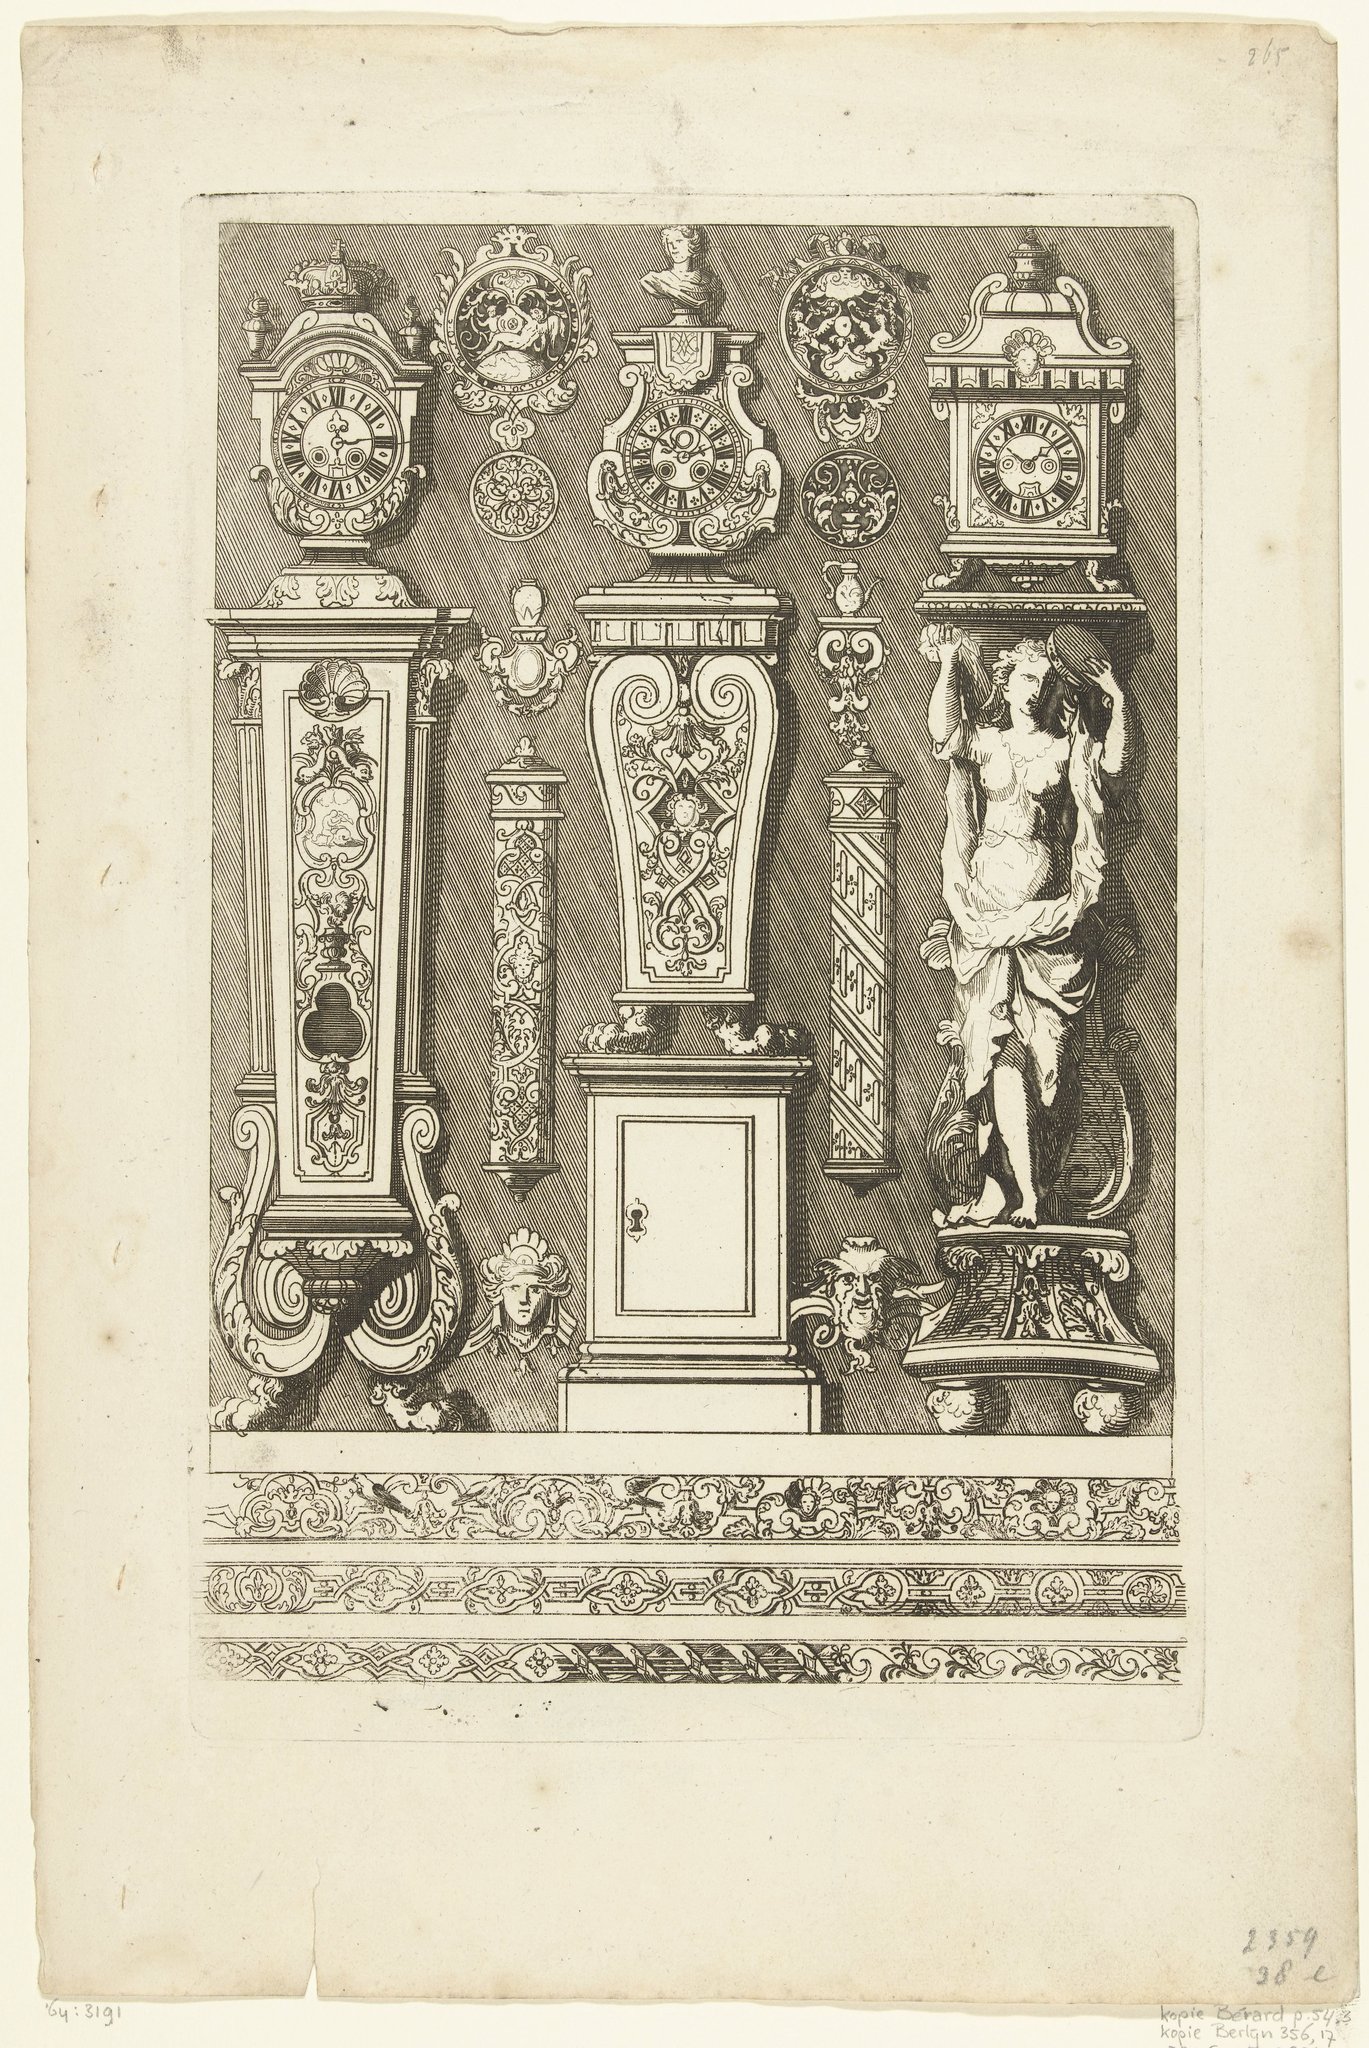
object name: print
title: Drie comtoise klokken en tien motieven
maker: Anonymous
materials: paper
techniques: etching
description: Met onderaan drie ornamentele randen met variaties. In de klok rechts zit een kariatide verwerkt. Uit serie van 6 bladen met kopieën naar prenten uit de serie Second Liure d'Orlogeries, uitgegeven door Daniel Marot.